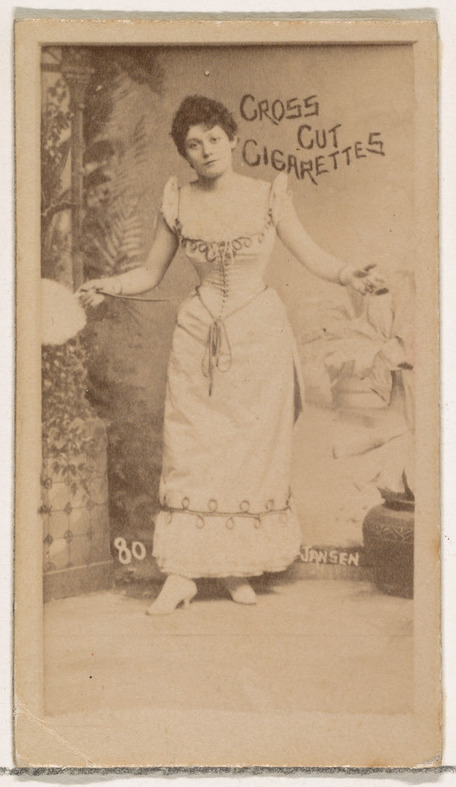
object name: print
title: Card Number 80, Jansen, from the Actors and Actresses series (N145-1) issued by Duke Sons & Co. to promote Cross Cut Cigarettes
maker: w. duke, sons & co.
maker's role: publisher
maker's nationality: american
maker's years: 1870-1920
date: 1880-1889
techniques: albumen silver print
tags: portraits,women,actresses